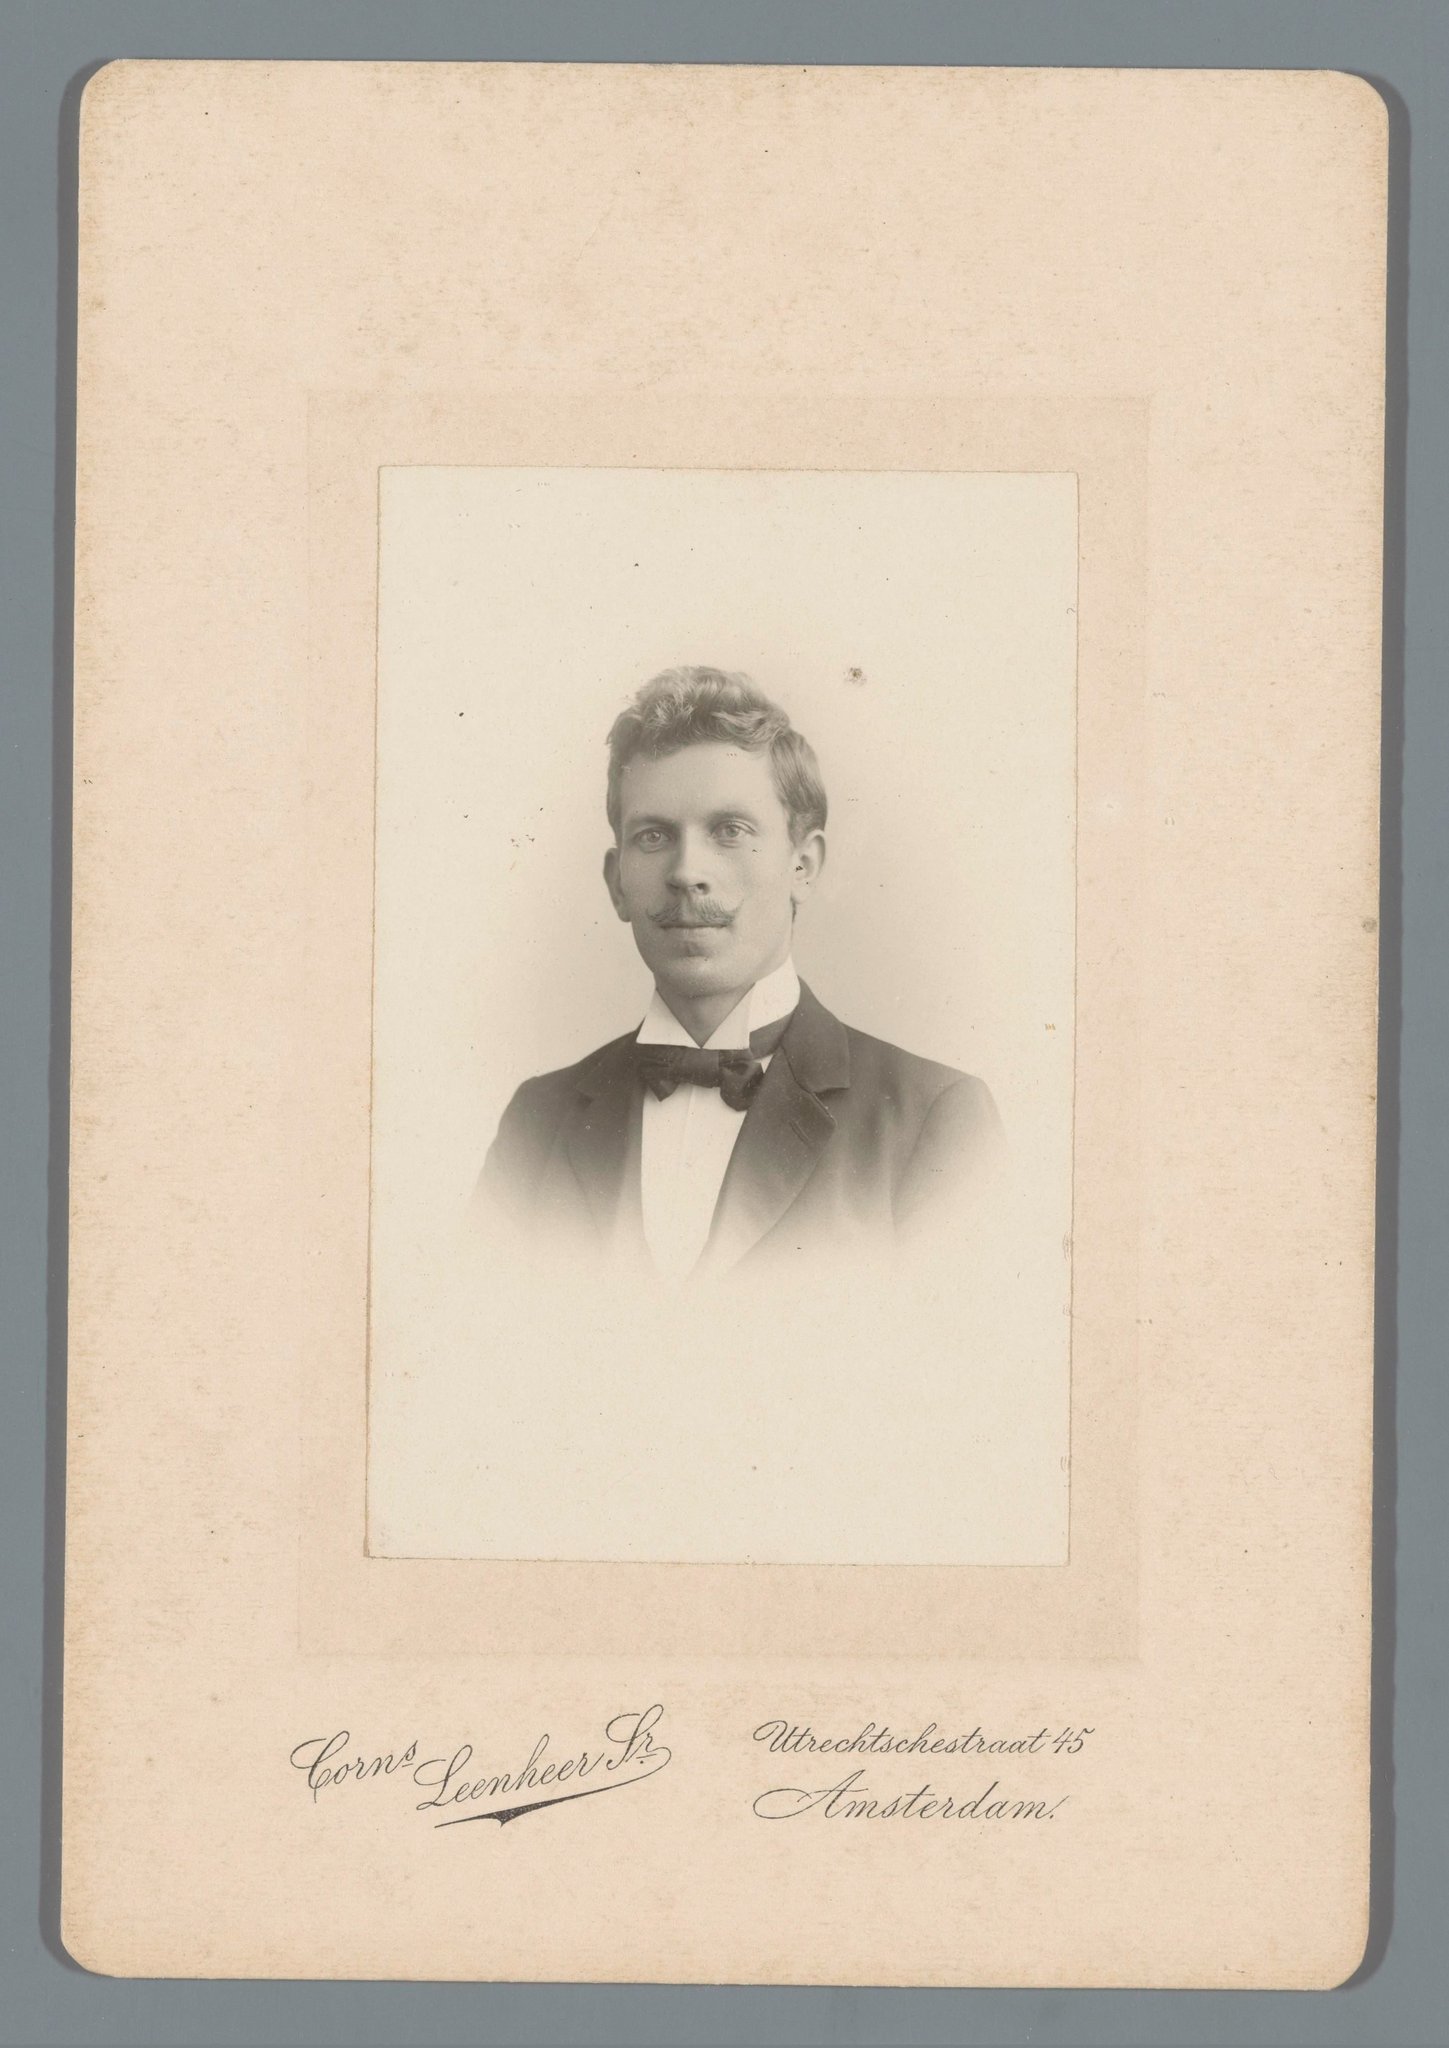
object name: cabinet photograph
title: Portret van een onbekende man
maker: cornelis leenheer sr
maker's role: fotograaf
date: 1910-1942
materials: cardboard, photographic support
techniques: gelatin silver print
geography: amsterdam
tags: moustache, adult man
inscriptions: name: ‘Corns Leenheer Sr Utrechtschestraat 45 Amsterdam’